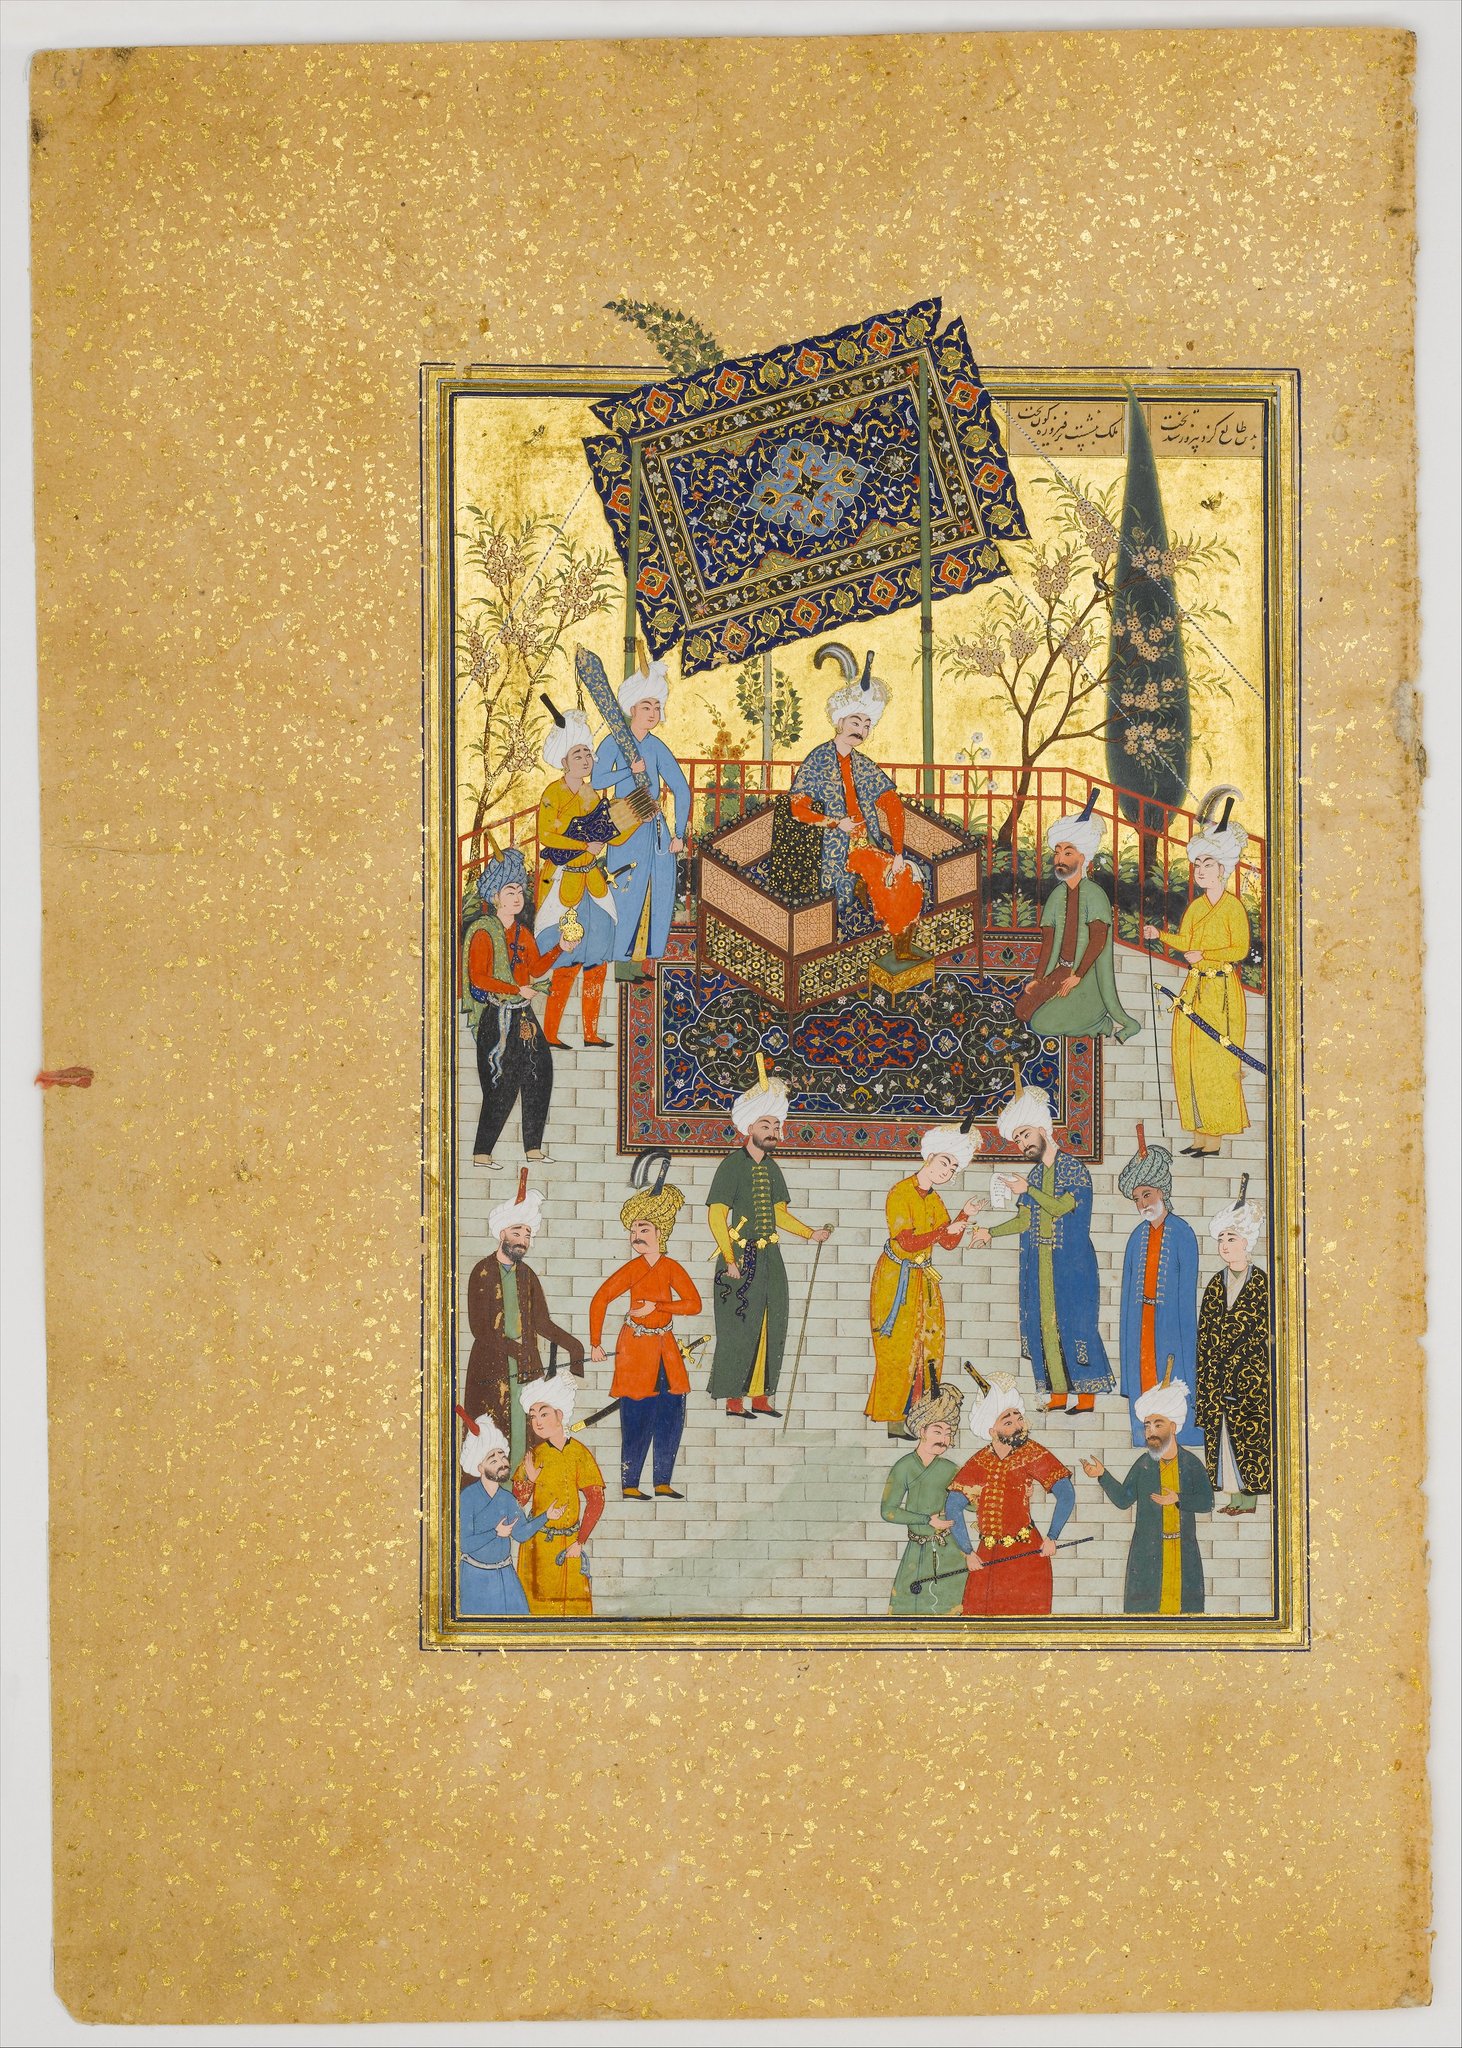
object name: folio from an illustrated manuscript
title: "Khusrau Seated on his Throne", Folio 64 from a Khamsa (Quintet) of Nizami of Ganja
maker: nizami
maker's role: author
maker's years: 1141-1209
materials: gold, ink, paper, watercolor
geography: afghanistan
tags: kings,men